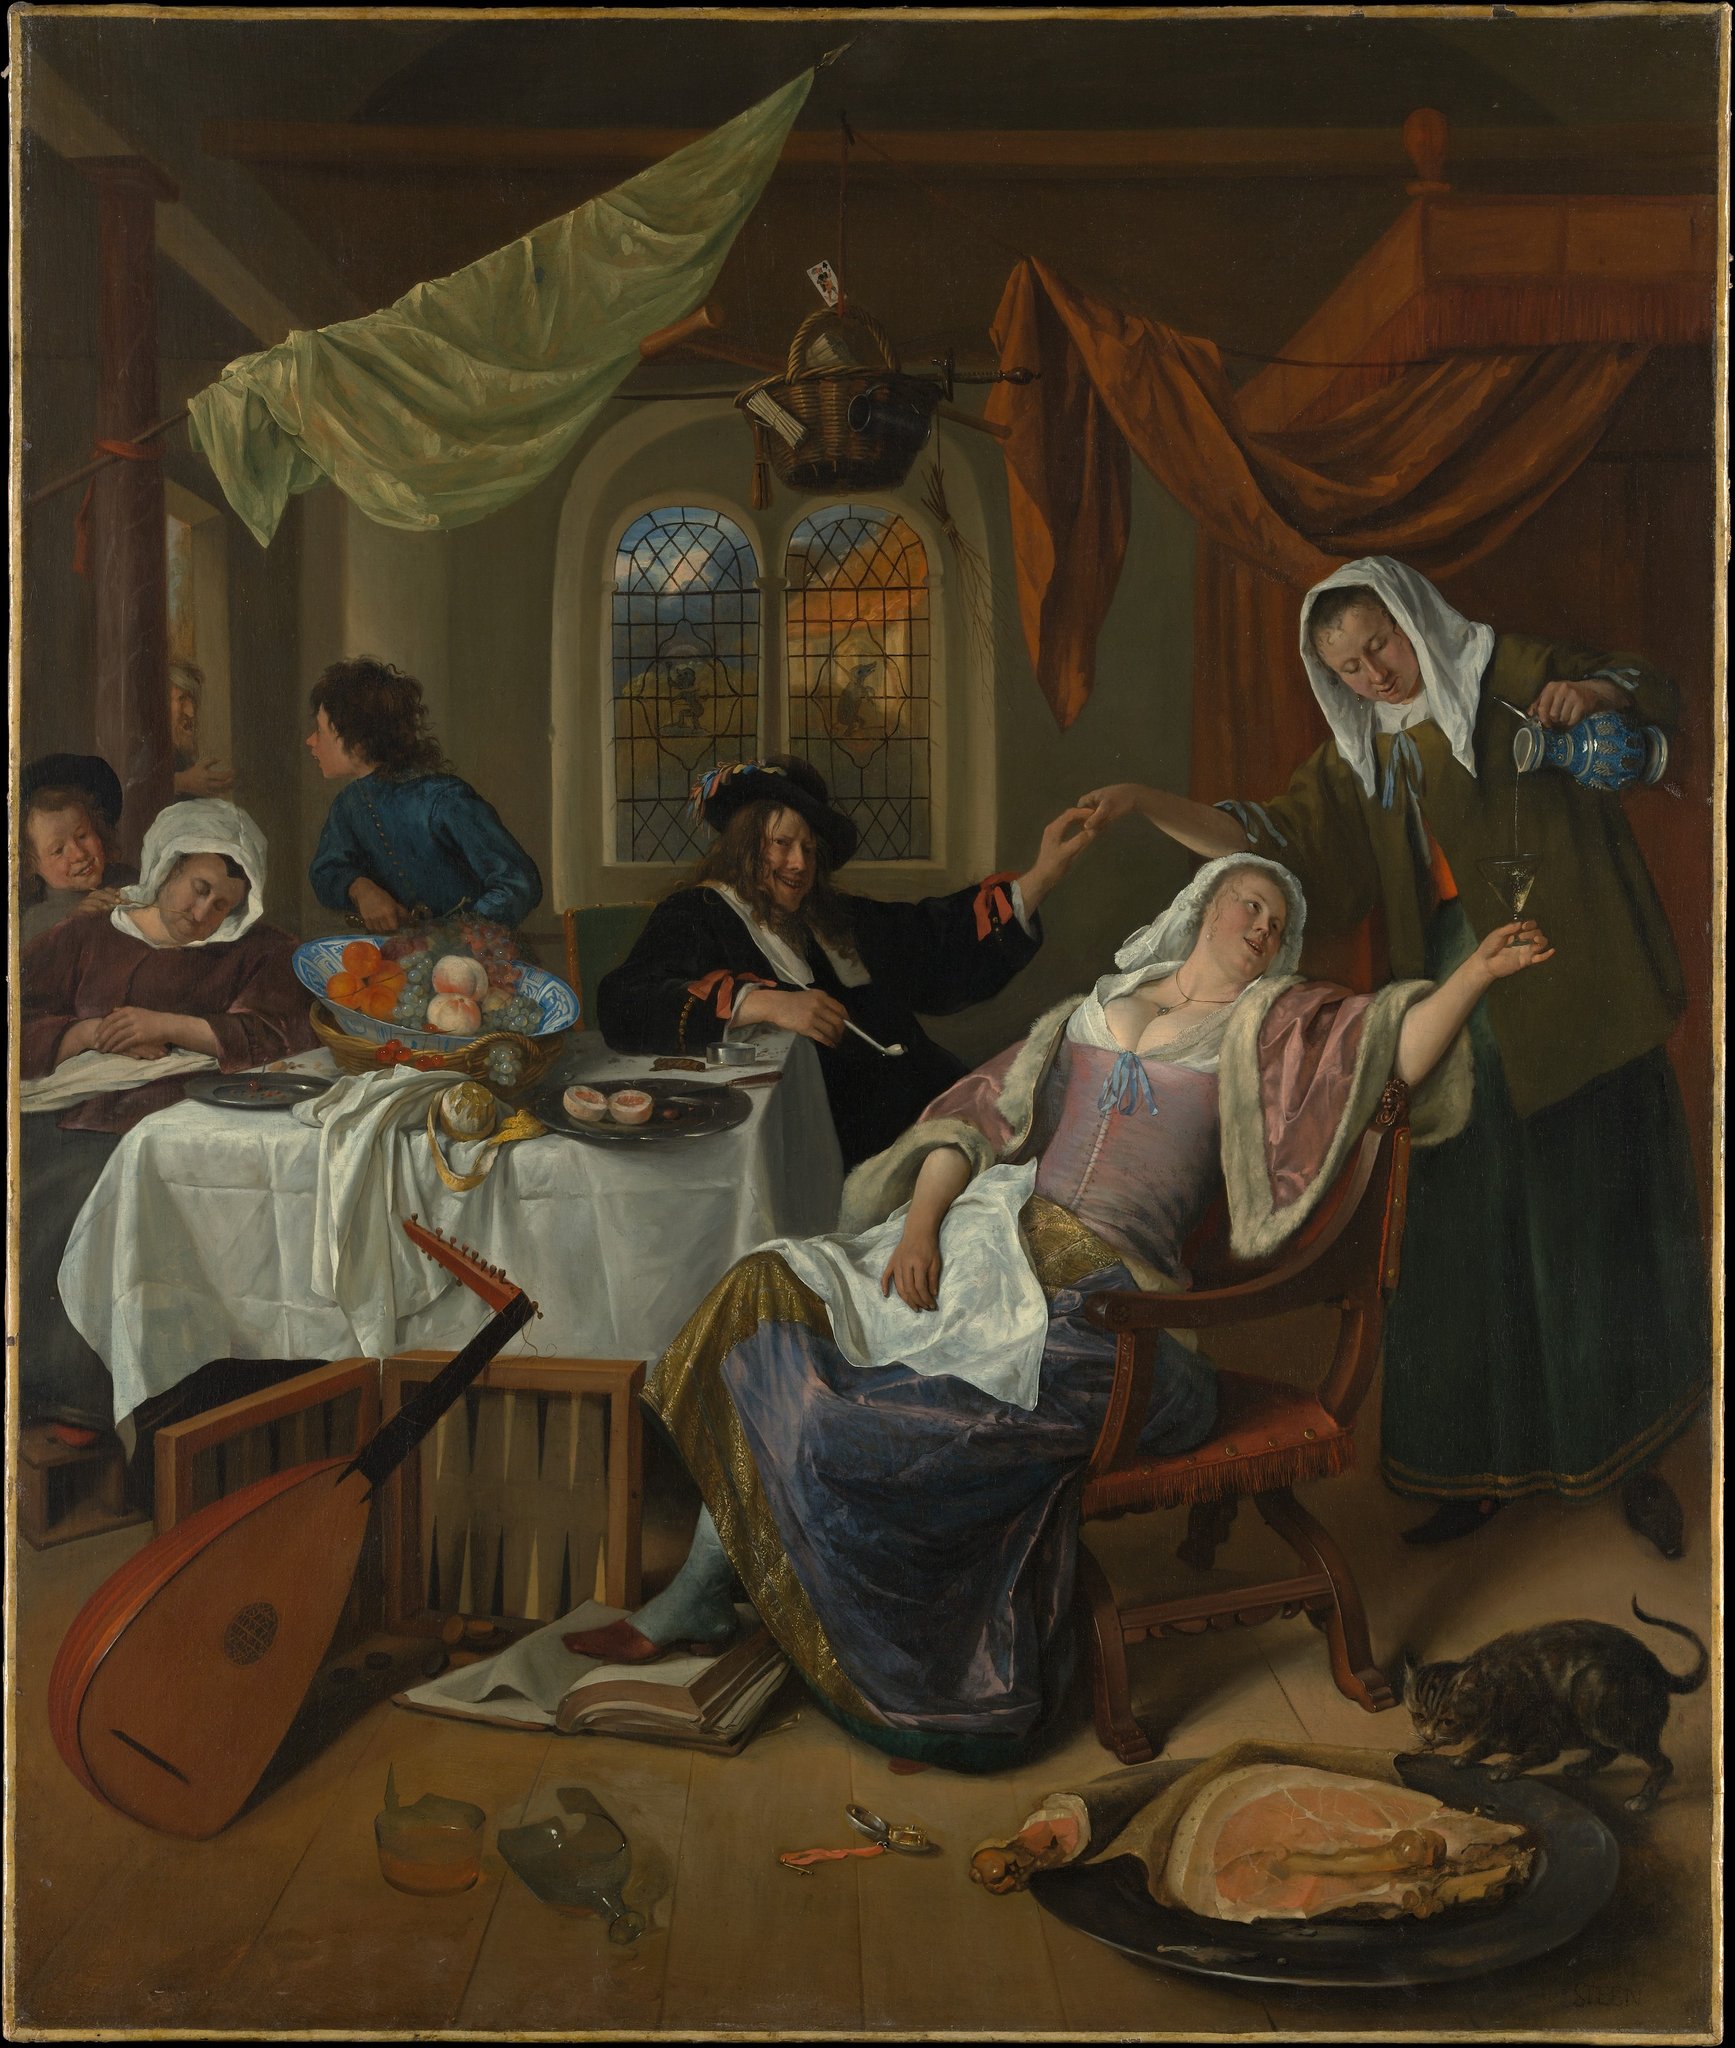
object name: painting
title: The Dissolute Household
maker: jan steen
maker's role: artist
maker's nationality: dutch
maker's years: 1626-1679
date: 1663-1664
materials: canvas, oil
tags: food,interiors,sleeping,men,women,lutes,cats,drinking,games